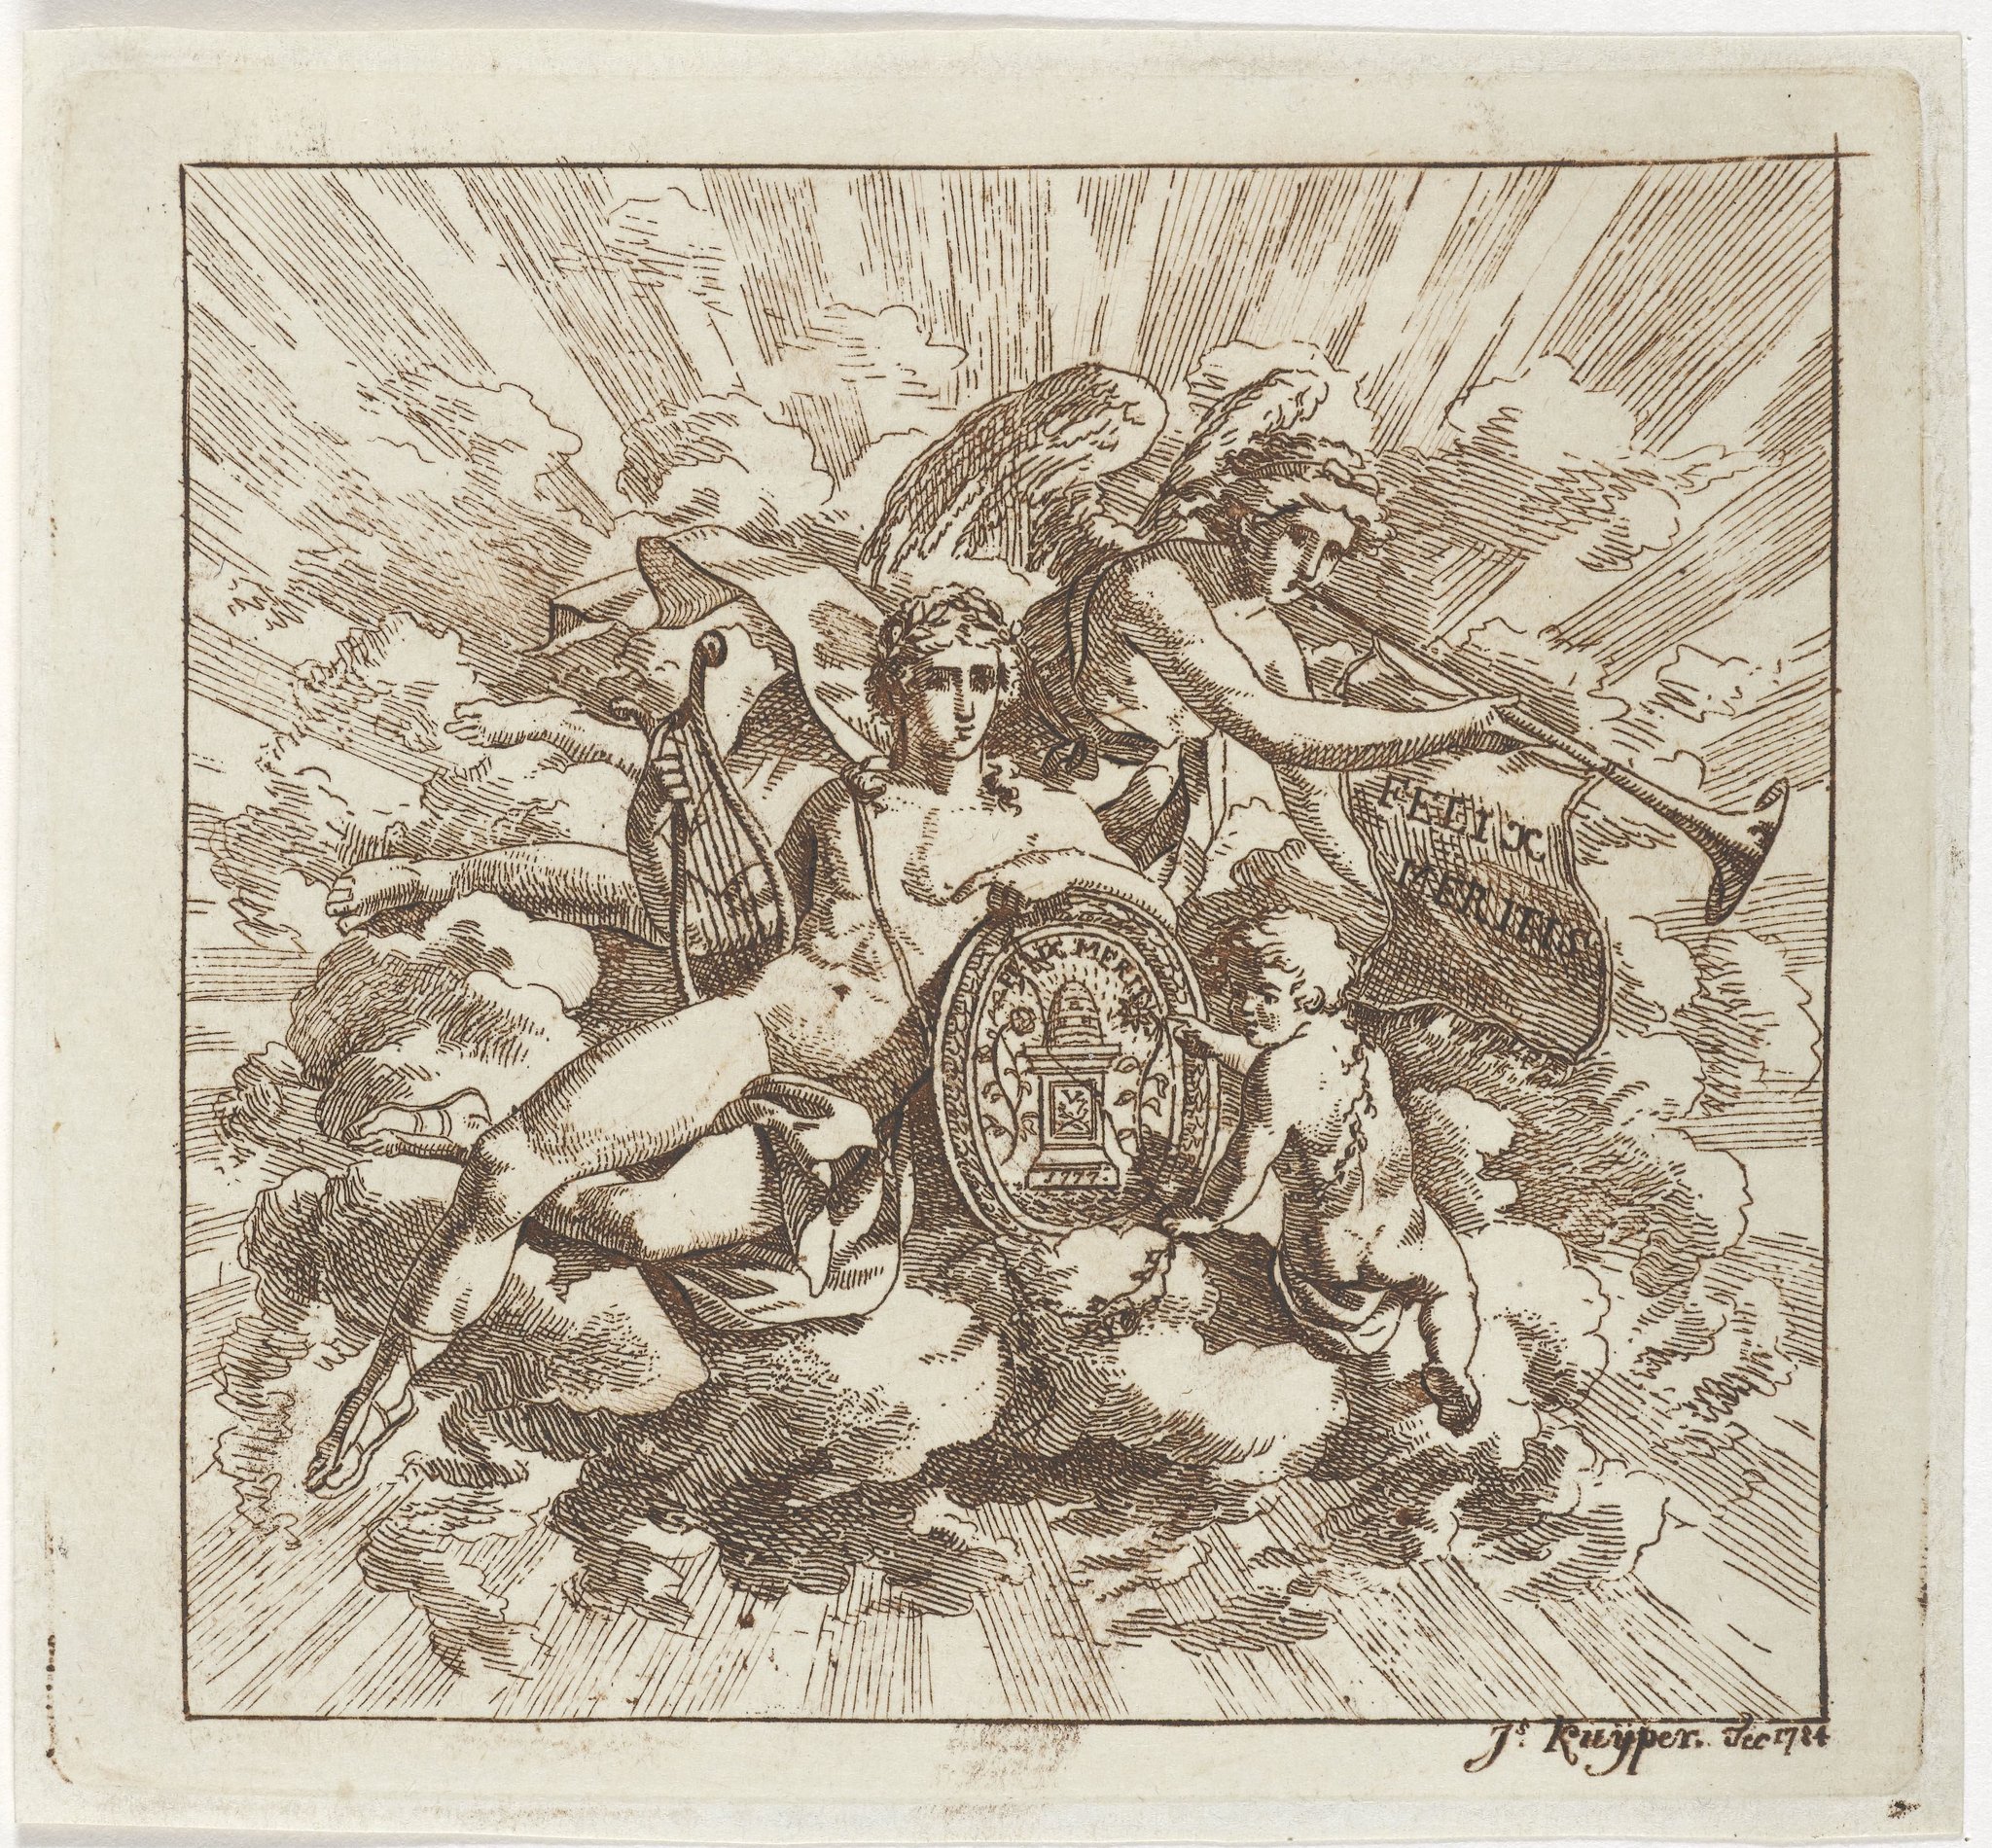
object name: print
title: Allegorische compositie op Felix Meritis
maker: jacques kuyper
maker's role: draughtsman, print maker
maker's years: 1761-1808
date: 1784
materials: paper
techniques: etching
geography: amsterdam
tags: (story of) apollo (phoebus), bee-hive, fame; 'fama', 'fama buona', 'fama chiara' (ripa), cupids: 'amores', 'amoretti', 'putti', amsterdam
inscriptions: collector's mark: Lugt 2228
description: Allegorische compositie op Felix Meritis met rechts de gevleugelde Faam die op de loftrompet blaast. Links rust Apollo, op de wolken gezeten, met de linkerarm op het blasoen van Felix Meritis dat ook door een putto wordt vastgehouden.